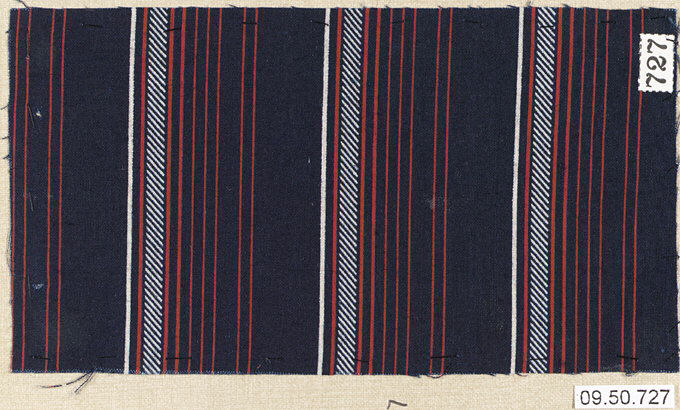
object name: piece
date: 1801-1900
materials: cotton